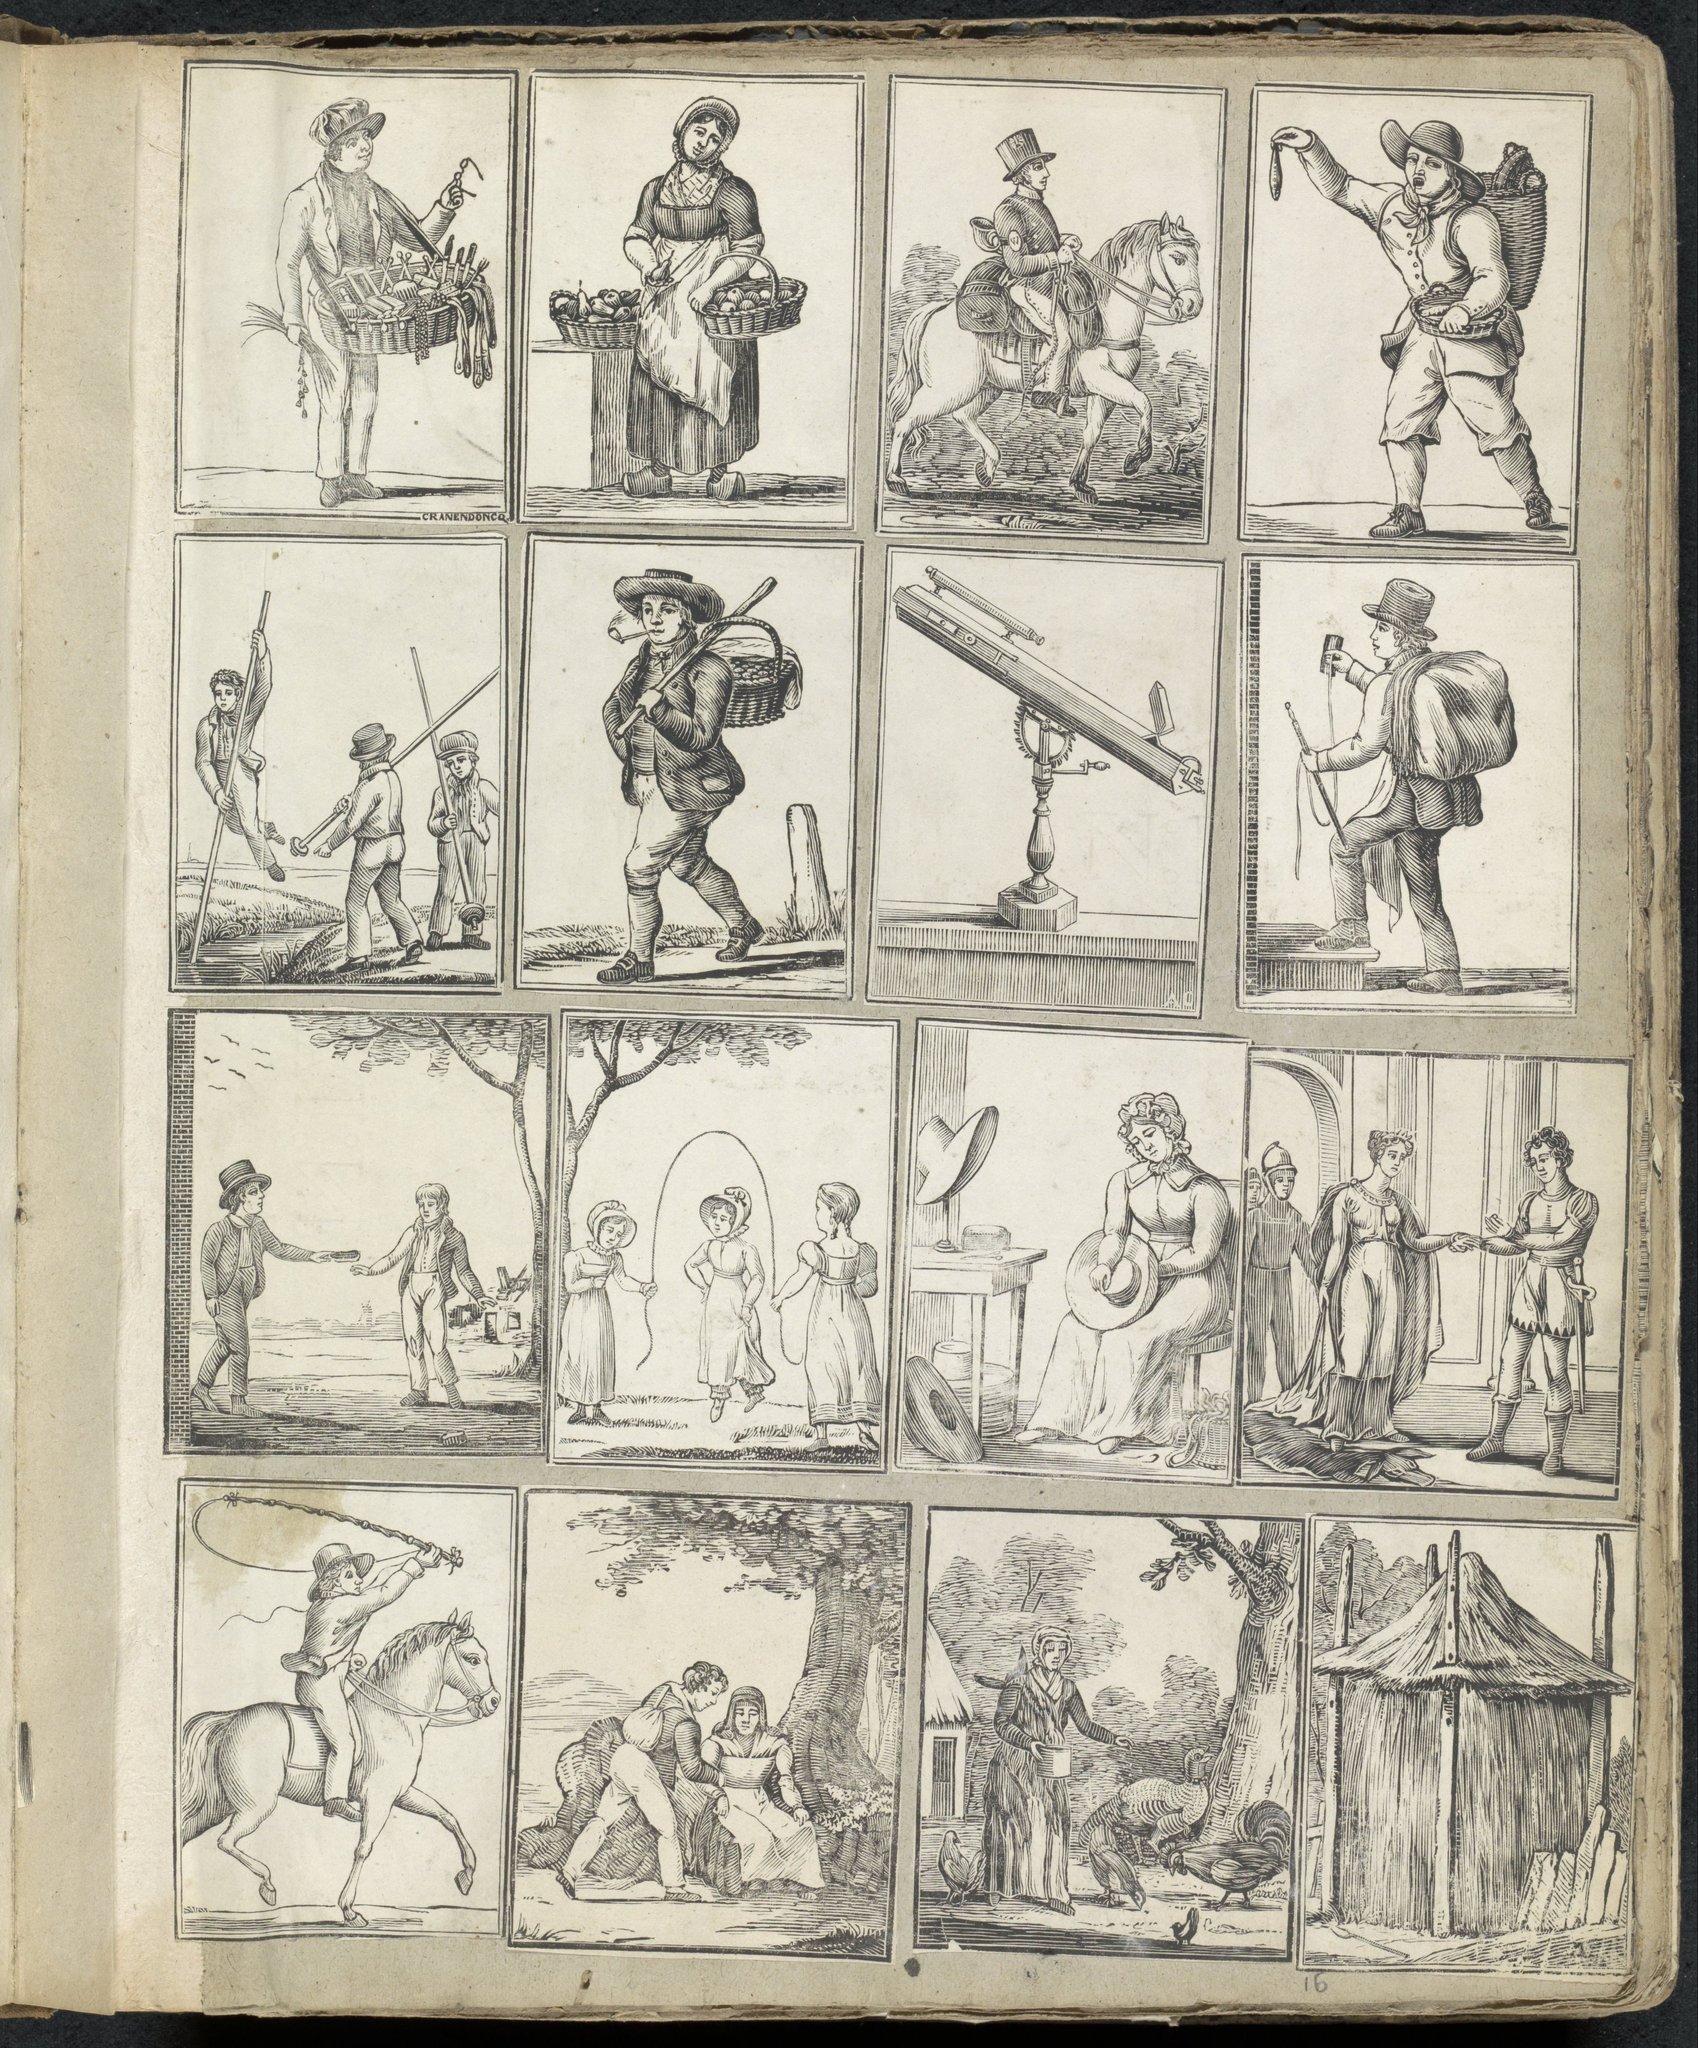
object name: print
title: Albumblad met diverse voorstellingen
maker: alexander cranendoncq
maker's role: draughtsman, print maker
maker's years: 1799-1869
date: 1814-1869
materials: paper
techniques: snipping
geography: nijmegen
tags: fowl (cock, hen, chicken, etc.) (+ feeding animal), children's games and plays, farmers - aa - female farmer, farmer's wife, street-trader, telescope, jumping-rope games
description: Albumblad met 16 uitgeknipte voorstellingen uit voornamelijk volksprenten, onder andere van straatverkopers, spelende kinderen, een telescoop en een boerin die kippen voert.